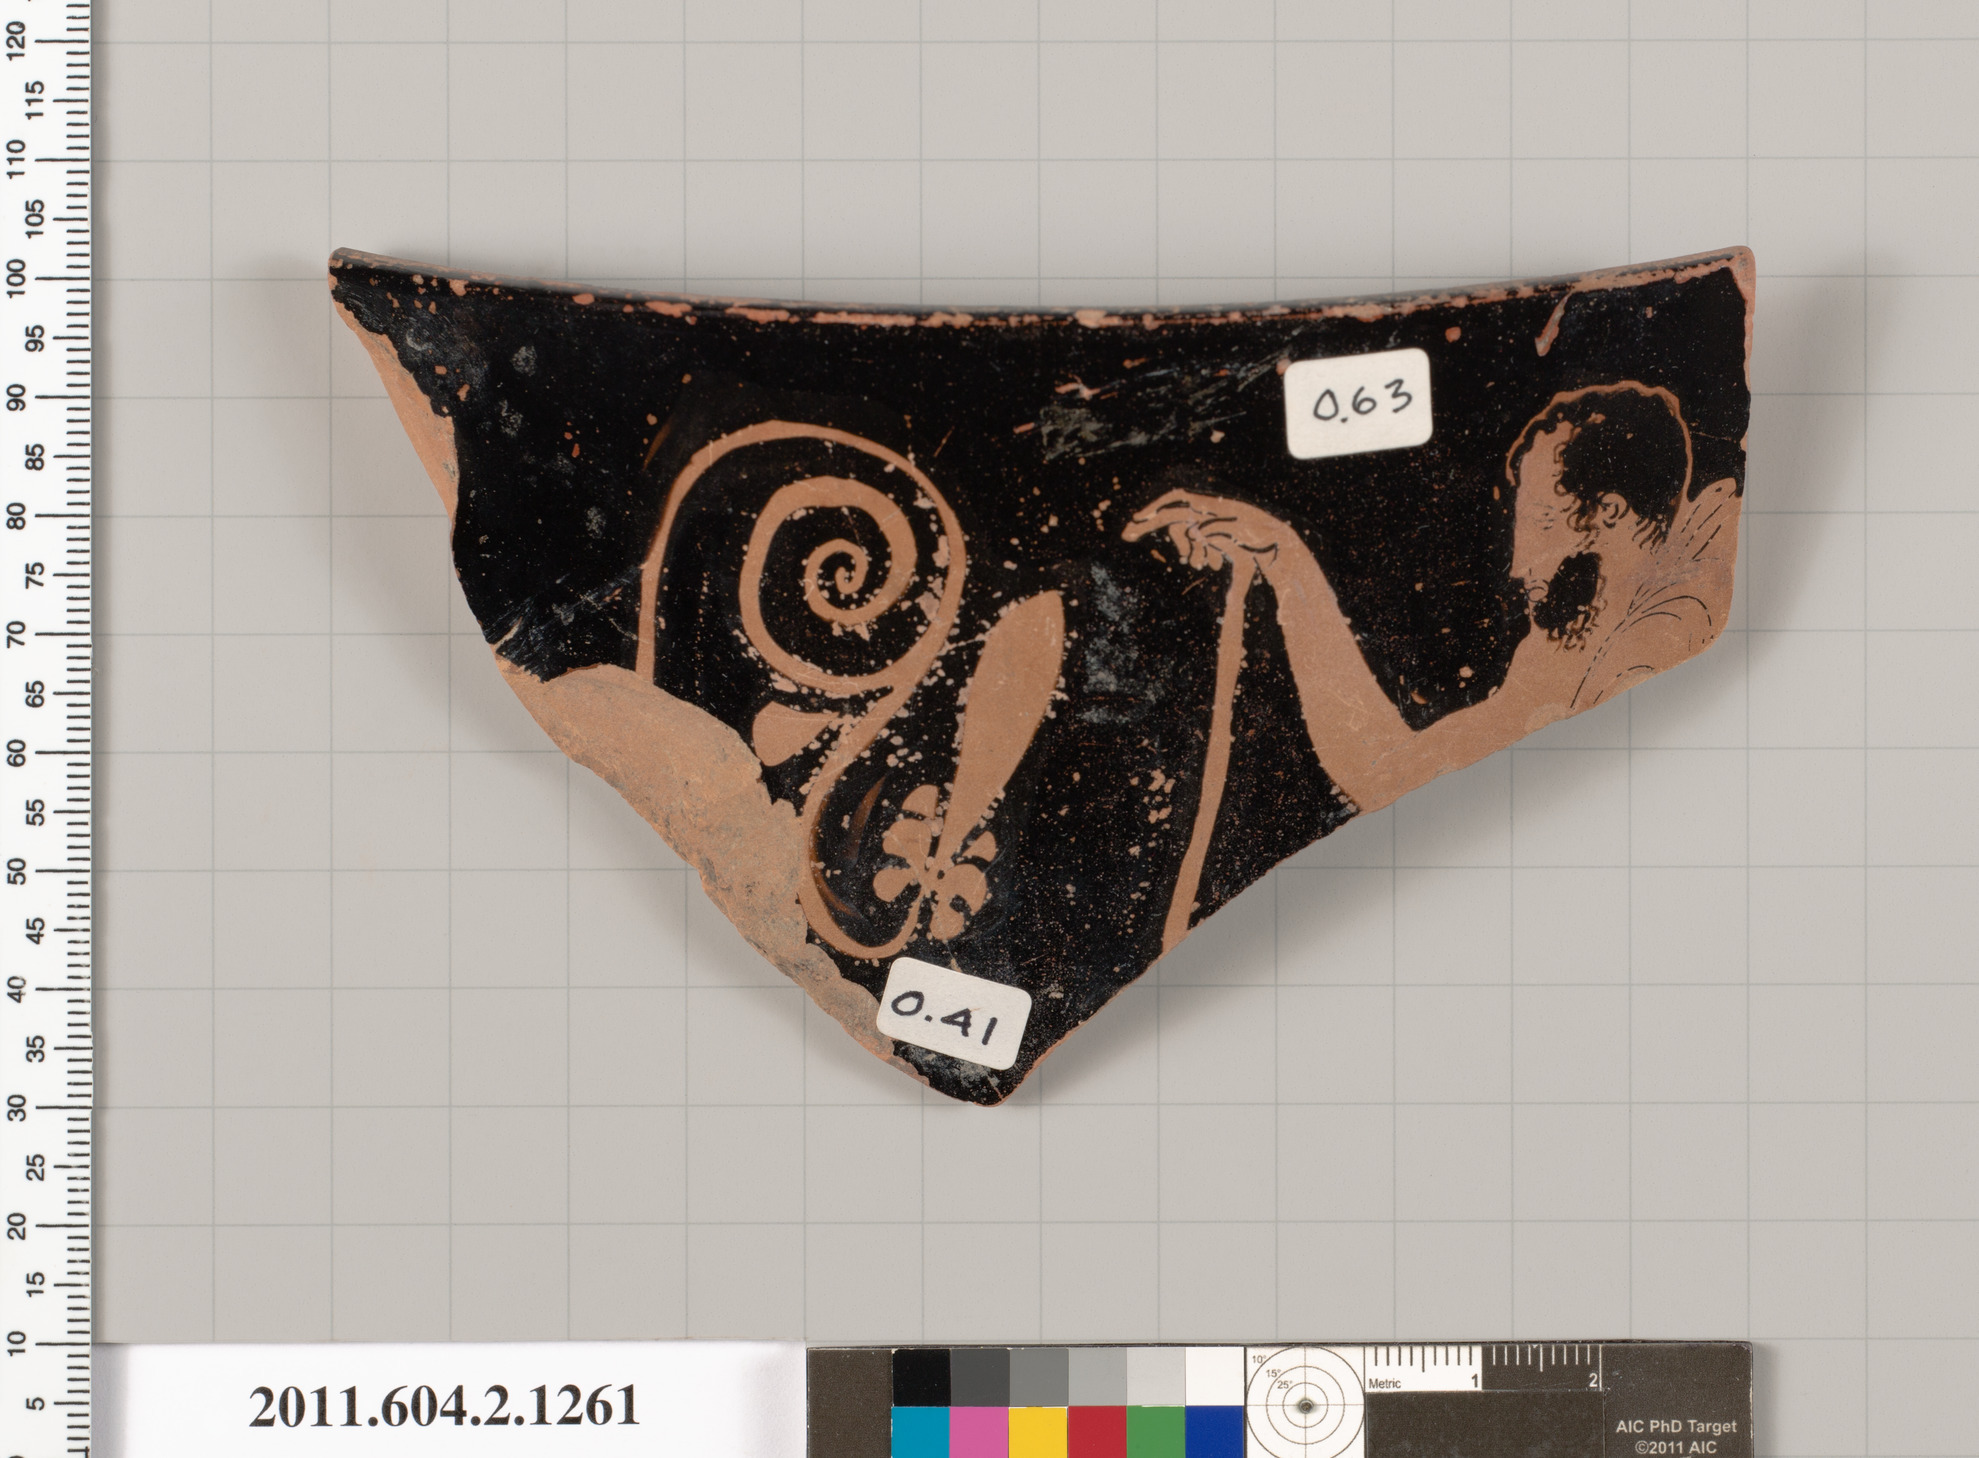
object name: skyphos fragment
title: Terracotta fragment of a skyphos (deep drinking cup)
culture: greek, attic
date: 450-430 BCE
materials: terracotta